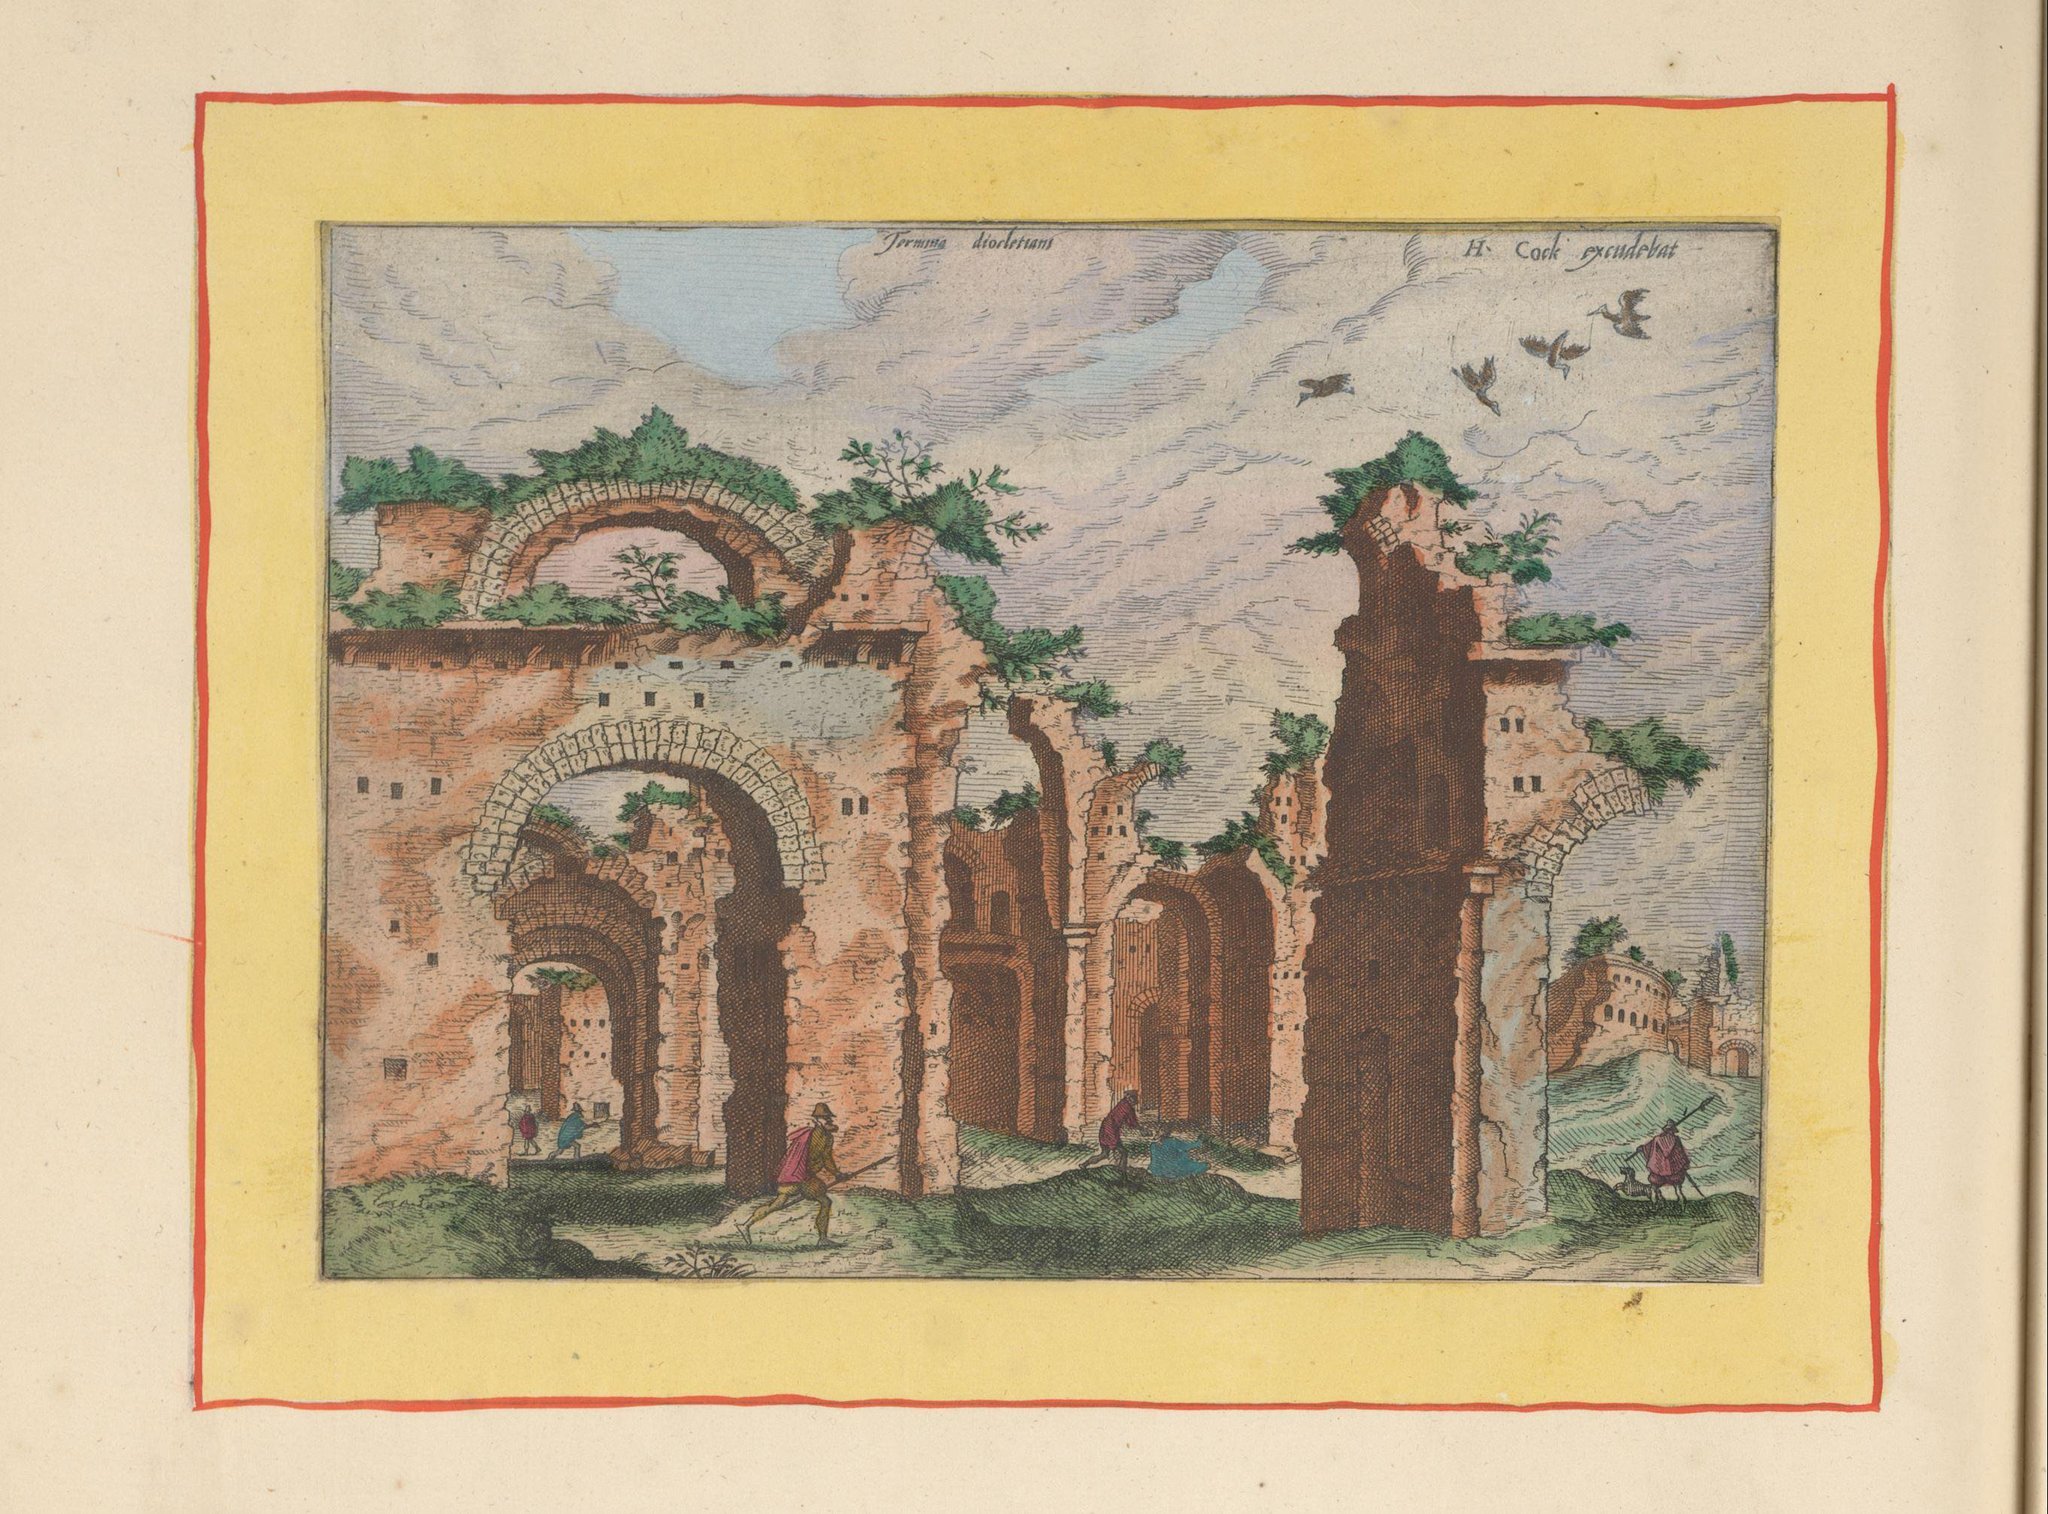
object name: album leaf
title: Thermen van Diocletianus te Rome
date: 1562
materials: paper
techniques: colour, etching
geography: antwerp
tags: ruin of a building ~ architecture, landscape with ruins, public baths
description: Gezicht op de ruïnes van de Thermen van Diocletianus te Rome. Tussen de resten lopen figuren. Prent maakt deel uit van een album.